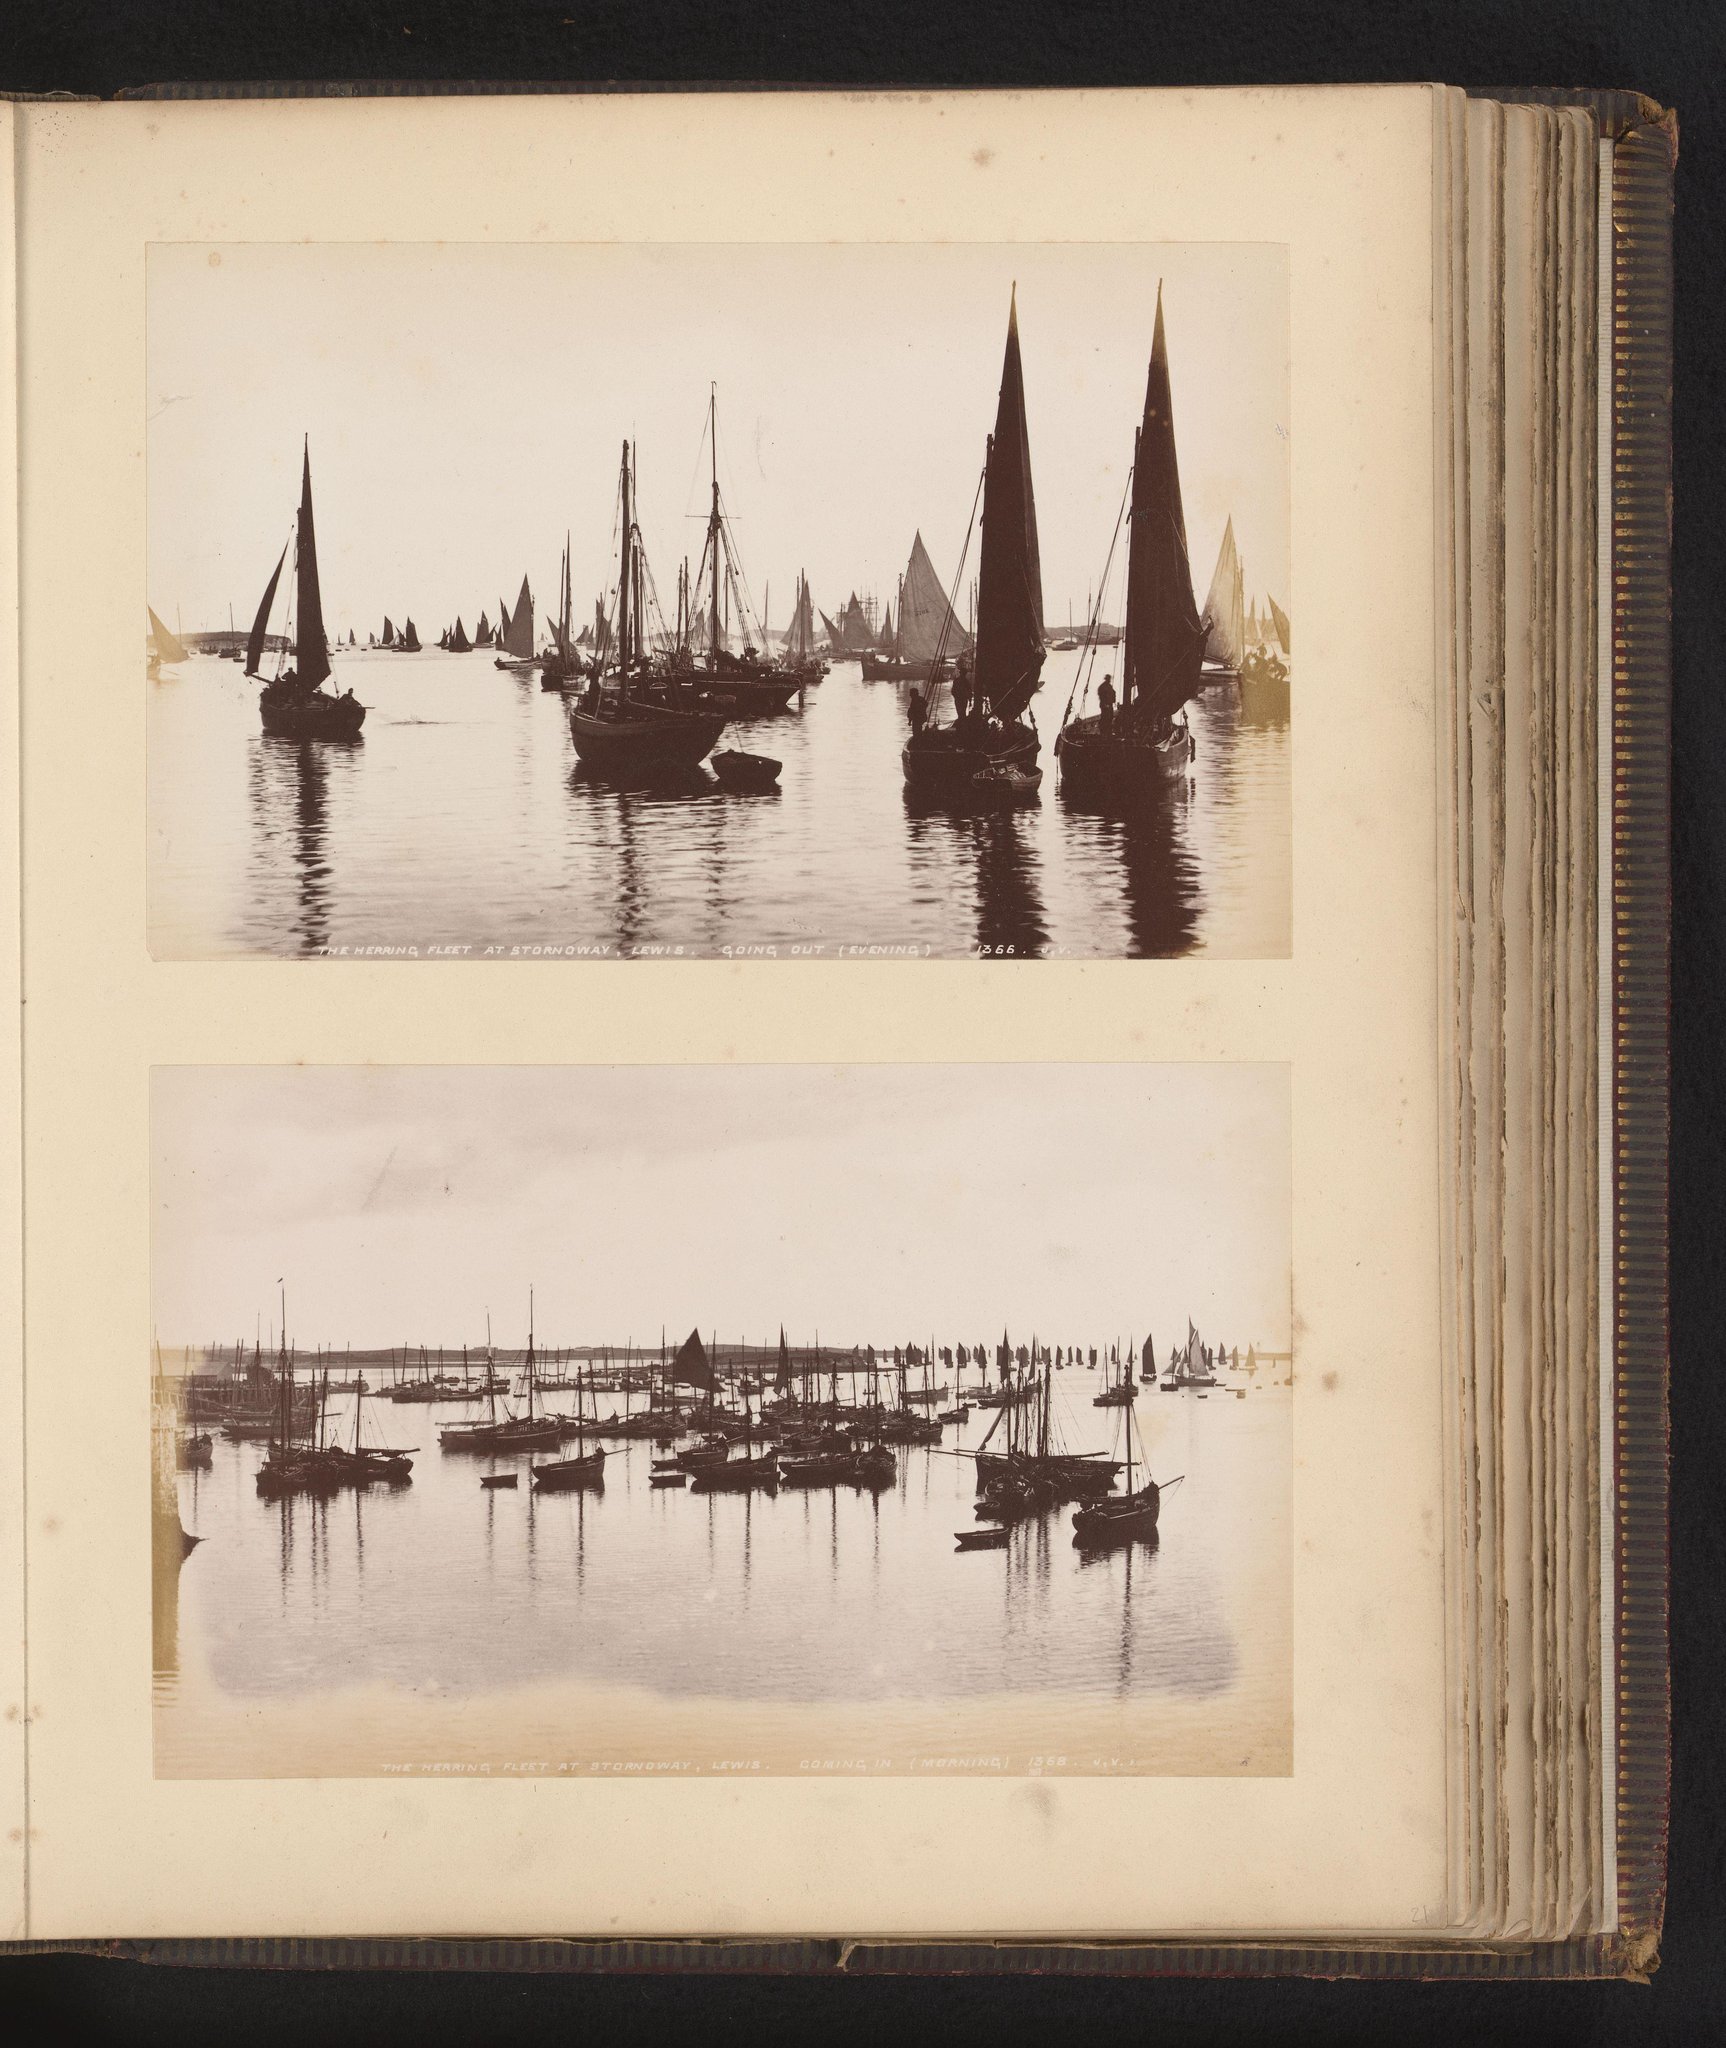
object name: album leaf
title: The herring fleet at Stornway, Lewis, going out (evening)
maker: Anonymous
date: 1875-1885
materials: photographic support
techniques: albumen print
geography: lewis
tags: commercial fishery, sailing-ship, sailing-boat, landscapes with waters, waterscapes, seascapes (in the temperate zone)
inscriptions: number: ‘1355, J.V.’, number: ‘1368, J.V.’